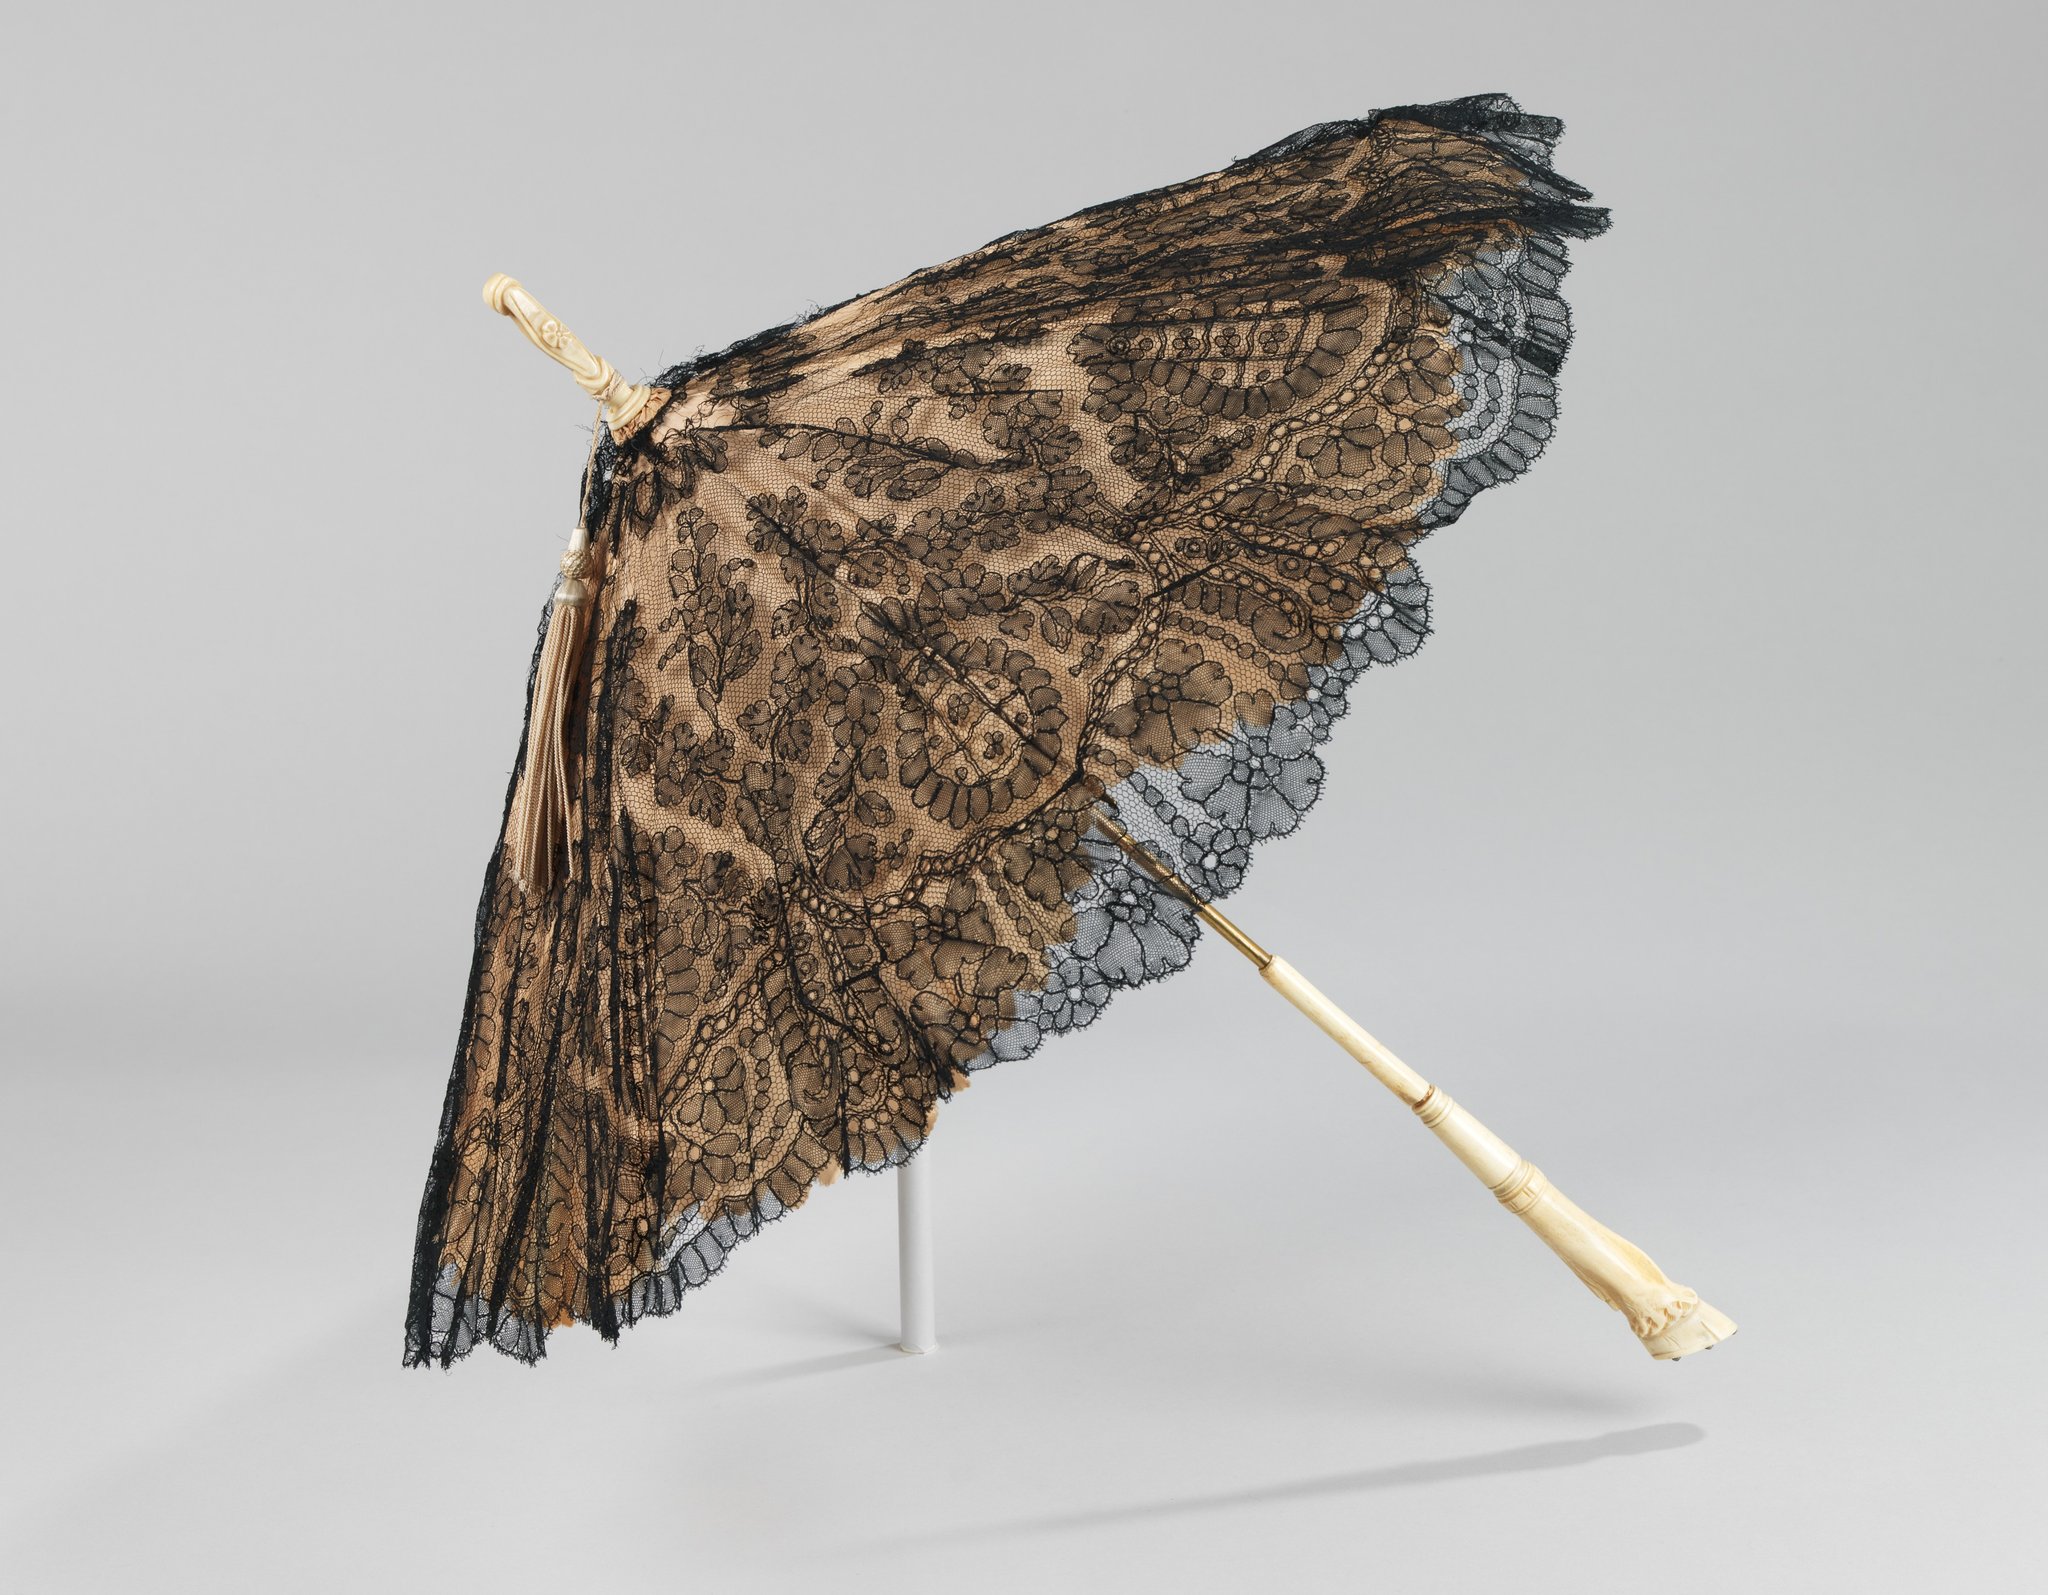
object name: parasol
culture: american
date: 1880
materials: ivory, metal, silk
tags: flowers